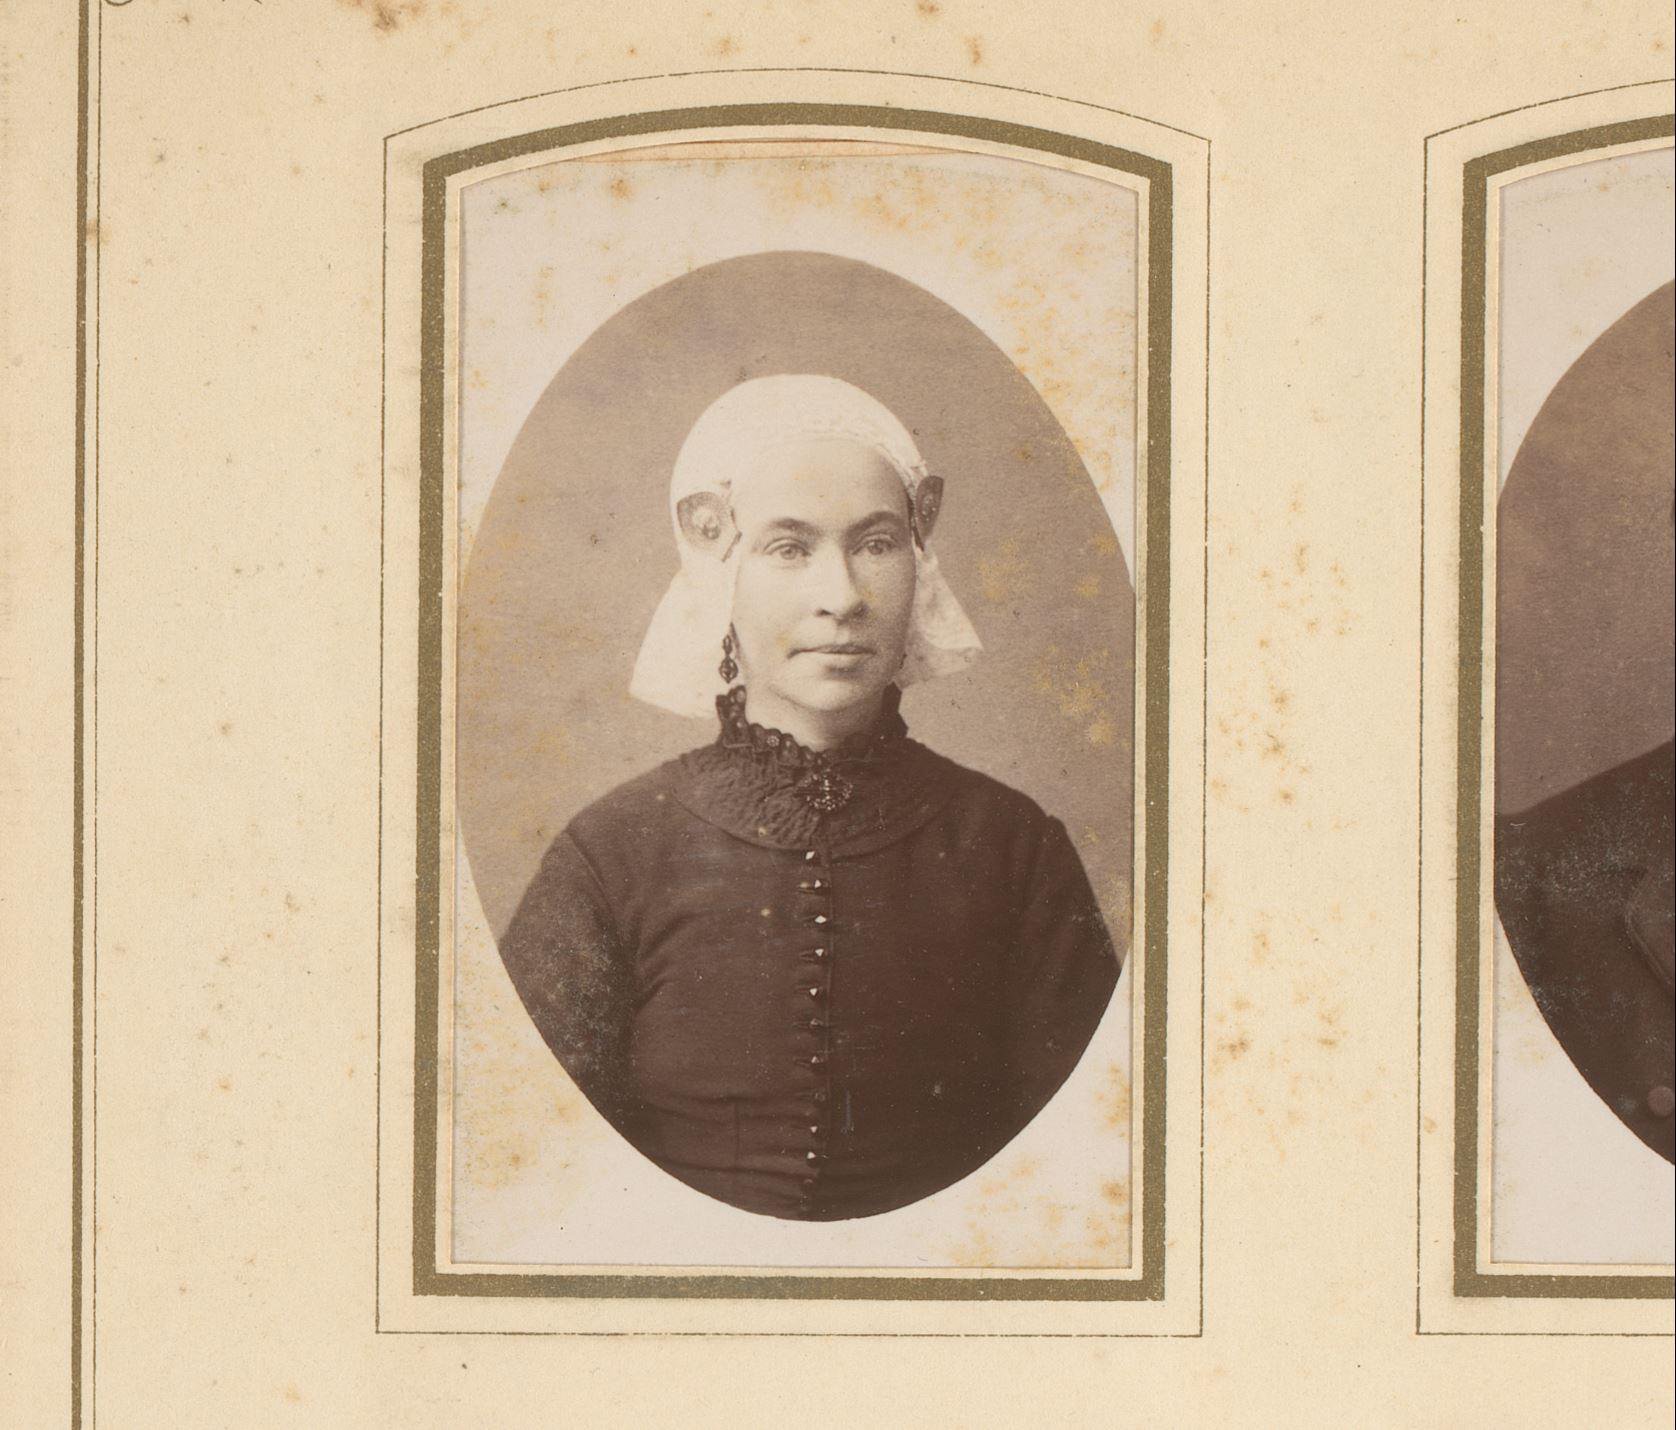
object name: album leaf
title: Portret van een vrouw met witte klederdrachtmuts en oorijzers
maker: idanus hendrikus slaterus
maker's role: fotograaf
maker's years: 1846-1921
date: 1873-1909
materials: cardboard, photographic support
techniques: albumen print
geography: leeuwarden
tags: historical persons - bb - woman, head-gear: cap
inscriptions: inscription: ‘Photographie/ I. H. Slaterus/ Leeuwarden/ Weerd K. 13,/ hoek Bagÿnestraat/ en/ Harlingen.’